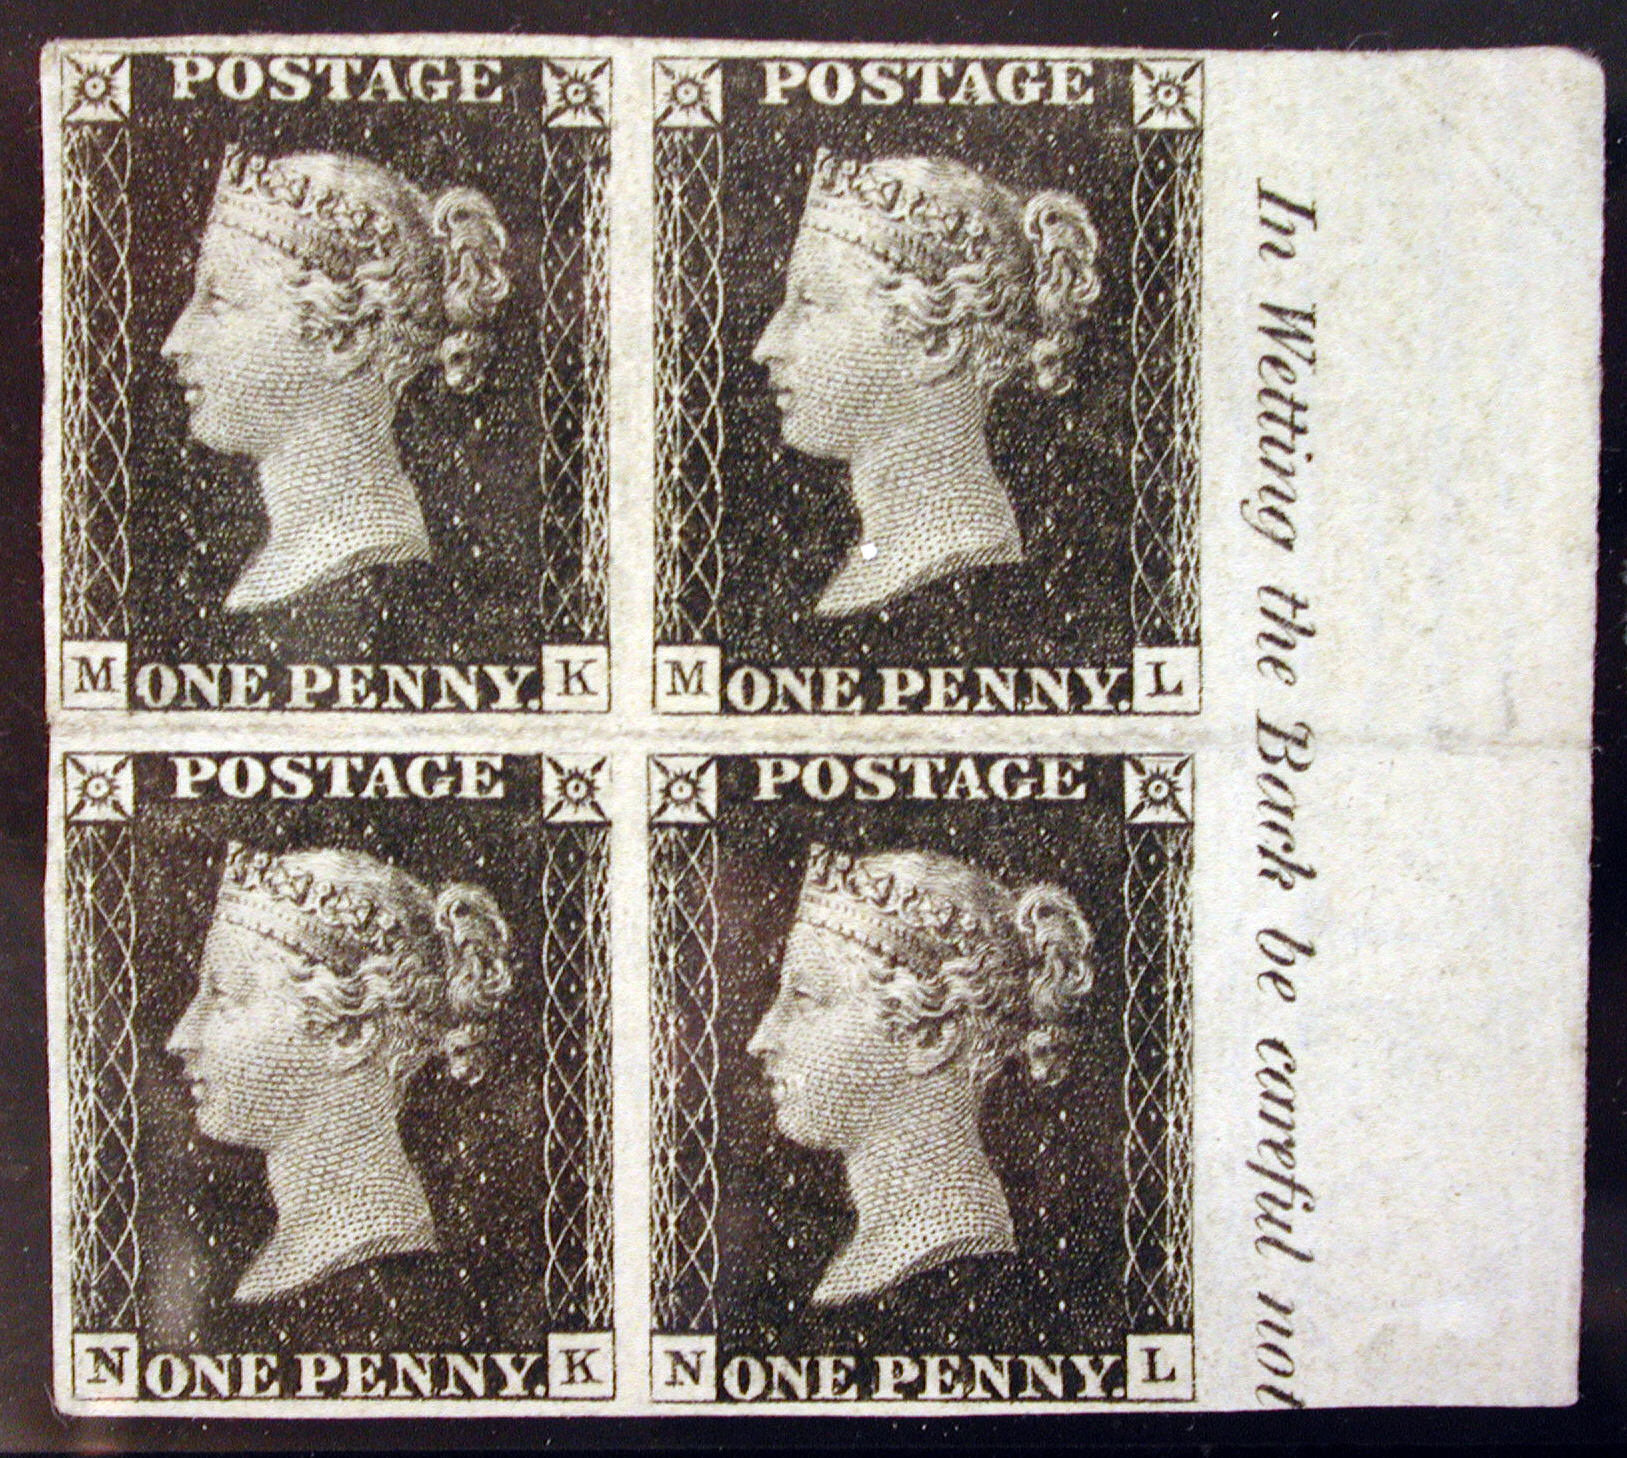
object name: postage stamp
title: Unused block of four "Penny Black" postage stamps of Queen Victoria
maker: william wyon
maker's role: artist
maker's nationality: british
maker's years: 1795-1851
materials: ink, paper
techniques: engraving, printing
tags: profiles,women,queen victoria